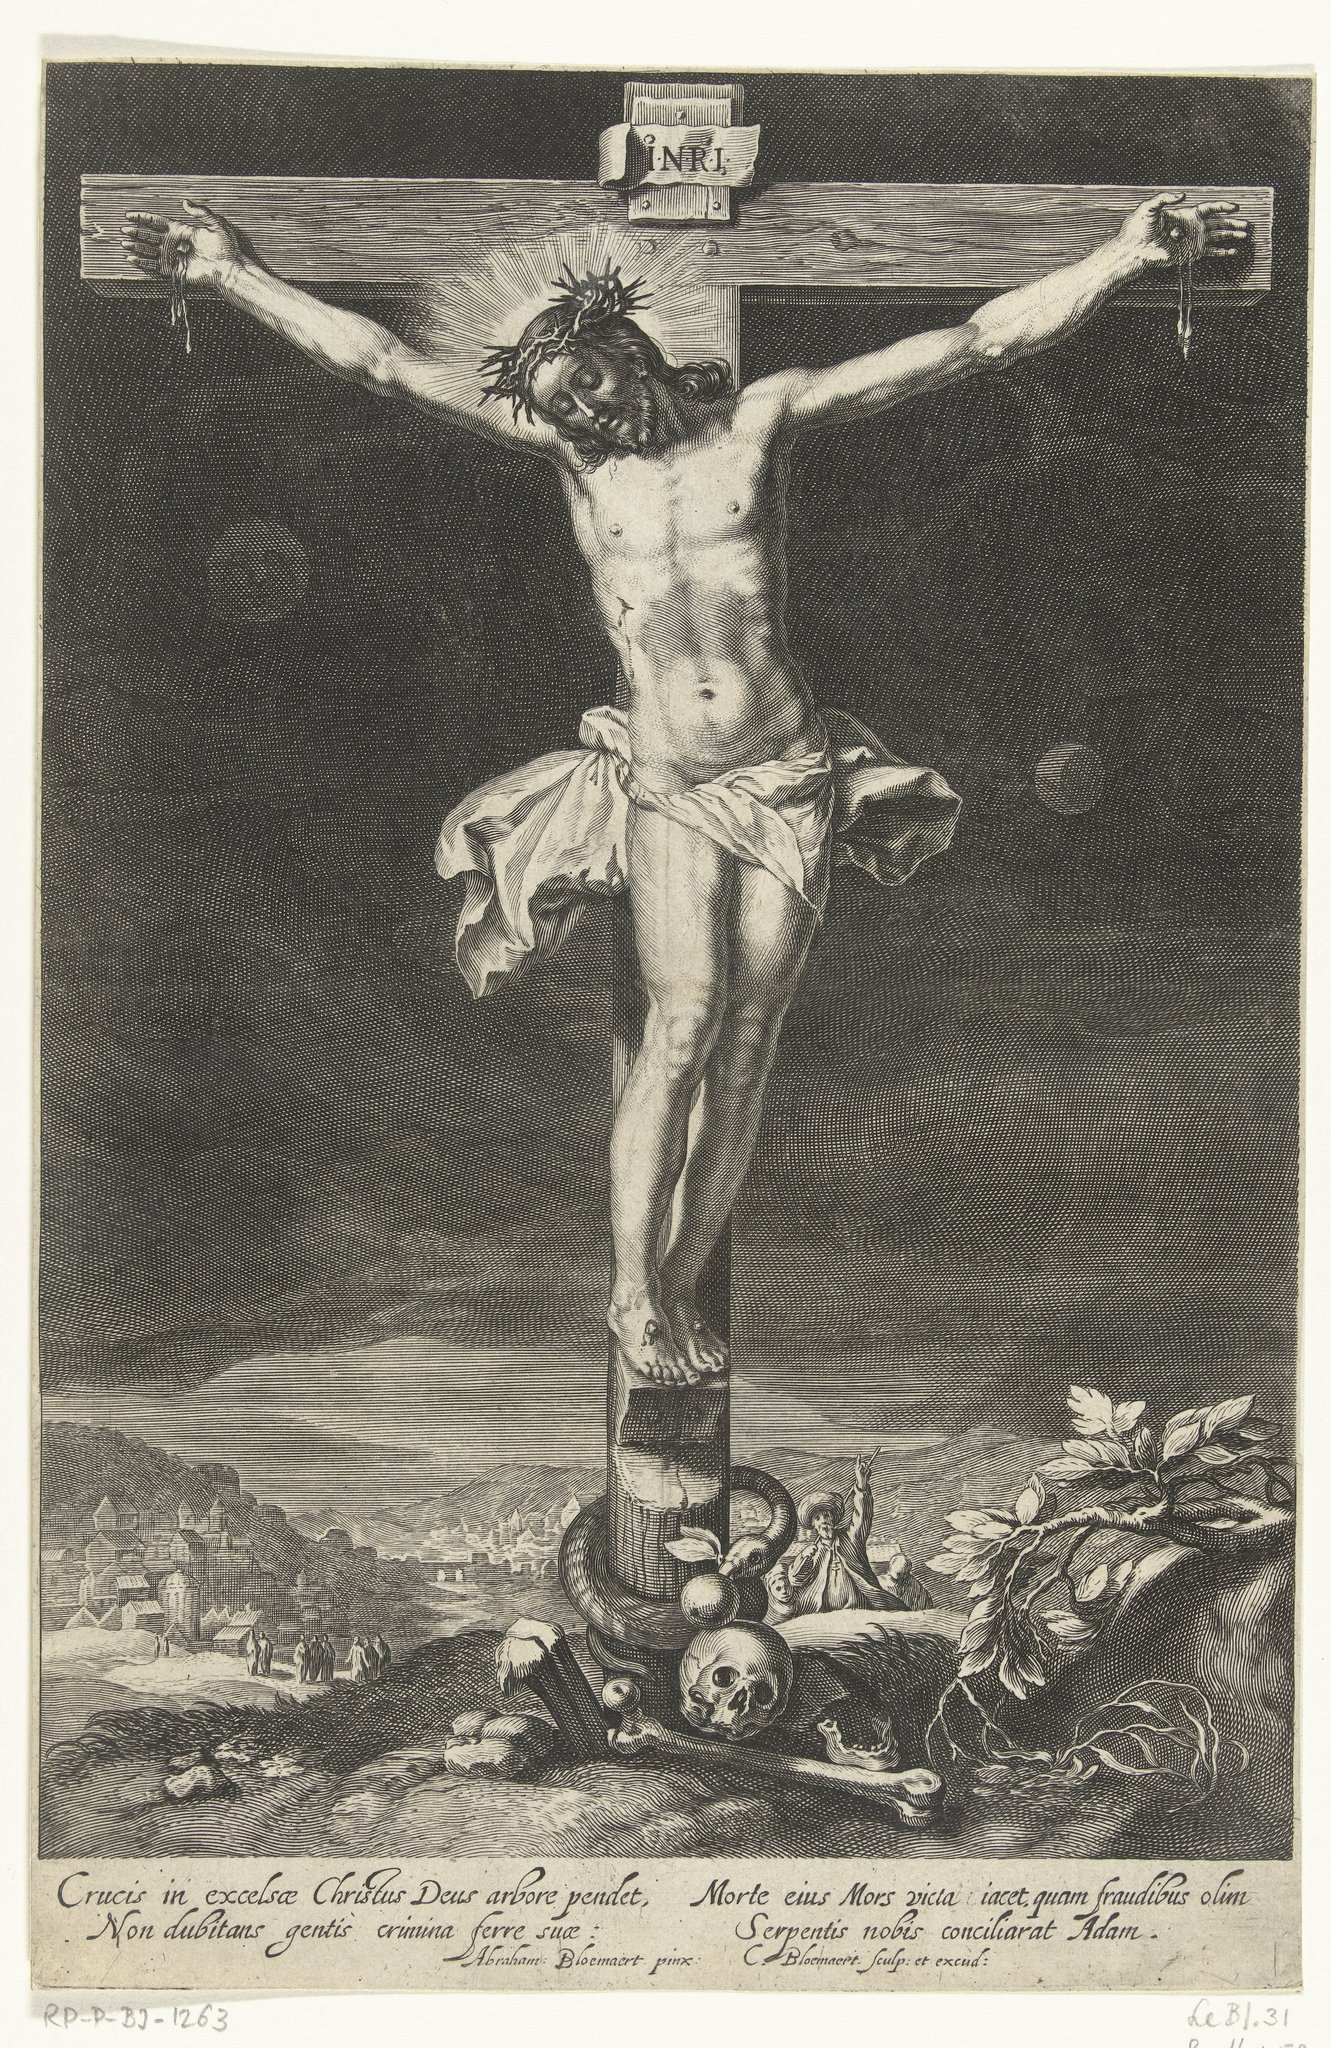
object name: print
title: Kruisiging van Christus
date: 1629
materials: paper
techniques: engraving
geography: utrecht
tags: the crucifixion of christ: christ's death on the cross; golgotha (matthew 27:45-58; mark 15:33-45; luke 23:44-52; john 19:25-38)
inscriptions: collector's mark: Lugt 240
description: Christus als eenzaam figuur aan het kruis genageld. Om de voet van het kruis een slang met een appel in de bek en een schedel. Aan de hemel staat links de zon, rechts de maan. Onder de voorstelling een vers met uitleg in het Latijn.